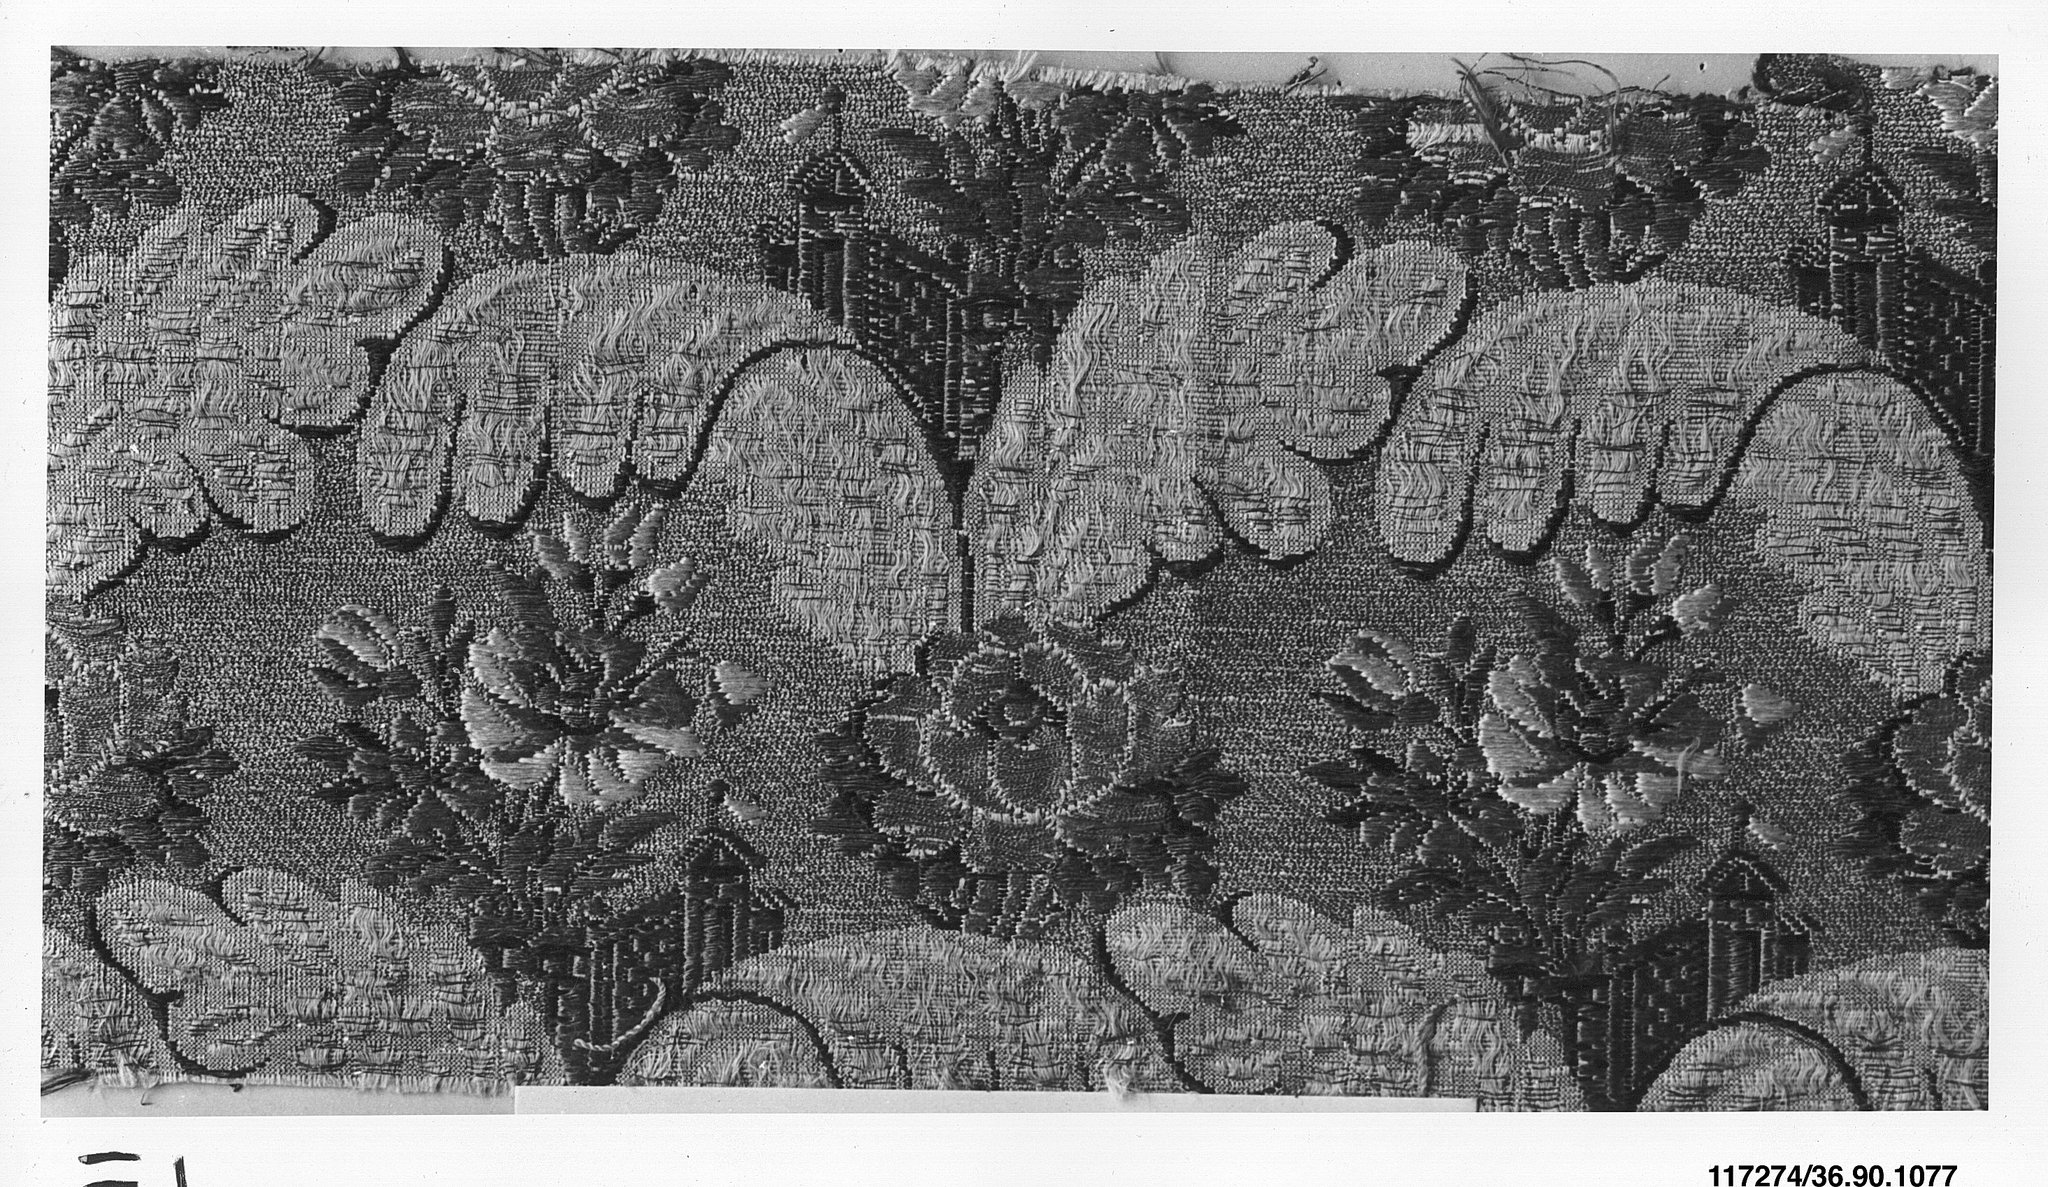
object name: piece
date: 1701-1900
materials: metal thread, silk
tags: flowers,leaves